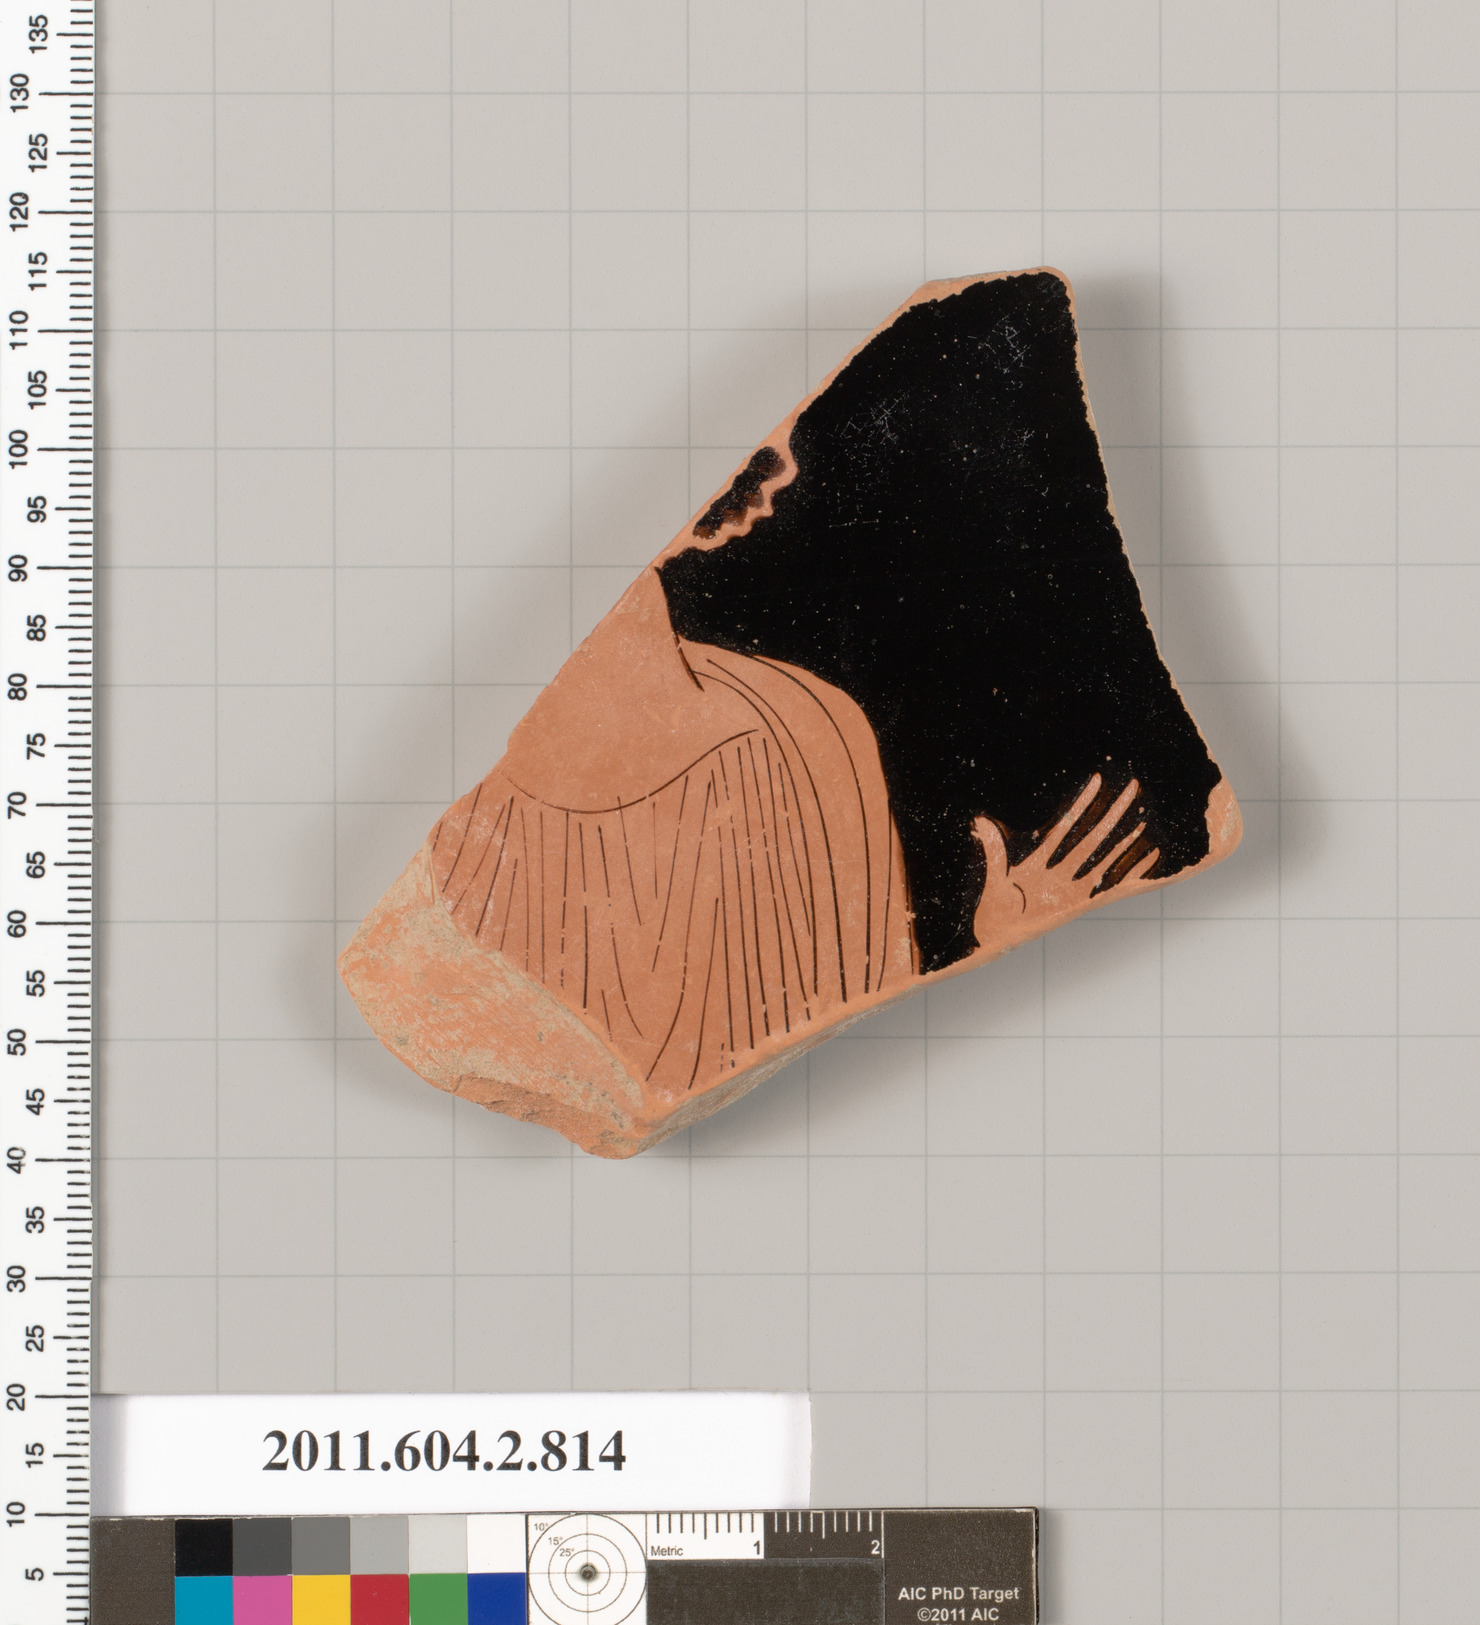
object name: bell krater fragment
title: Terracotta fragment of a bell-krater (bowl for mixing wine and water)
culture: greek, attic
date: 460-450 BCE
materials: terracotta